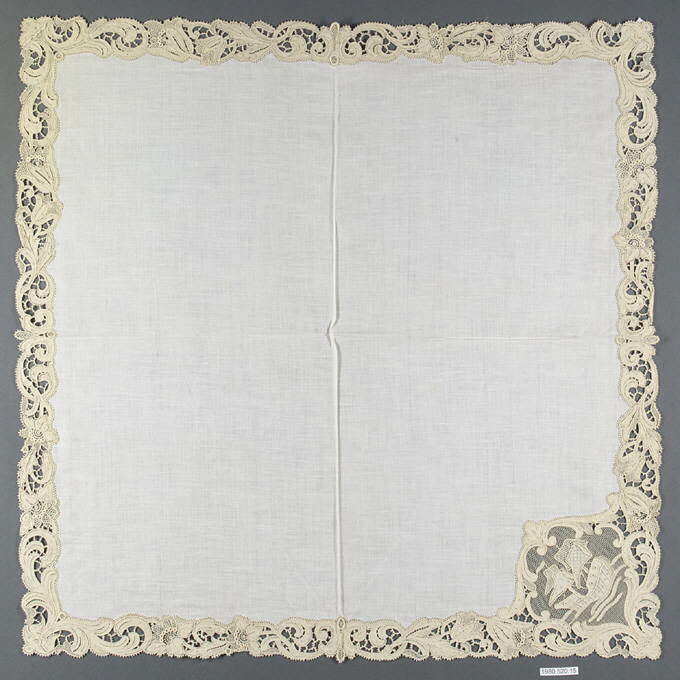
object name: napkin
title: Napkin (from a set of table linens)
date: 1867-1900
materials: linen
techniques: lace